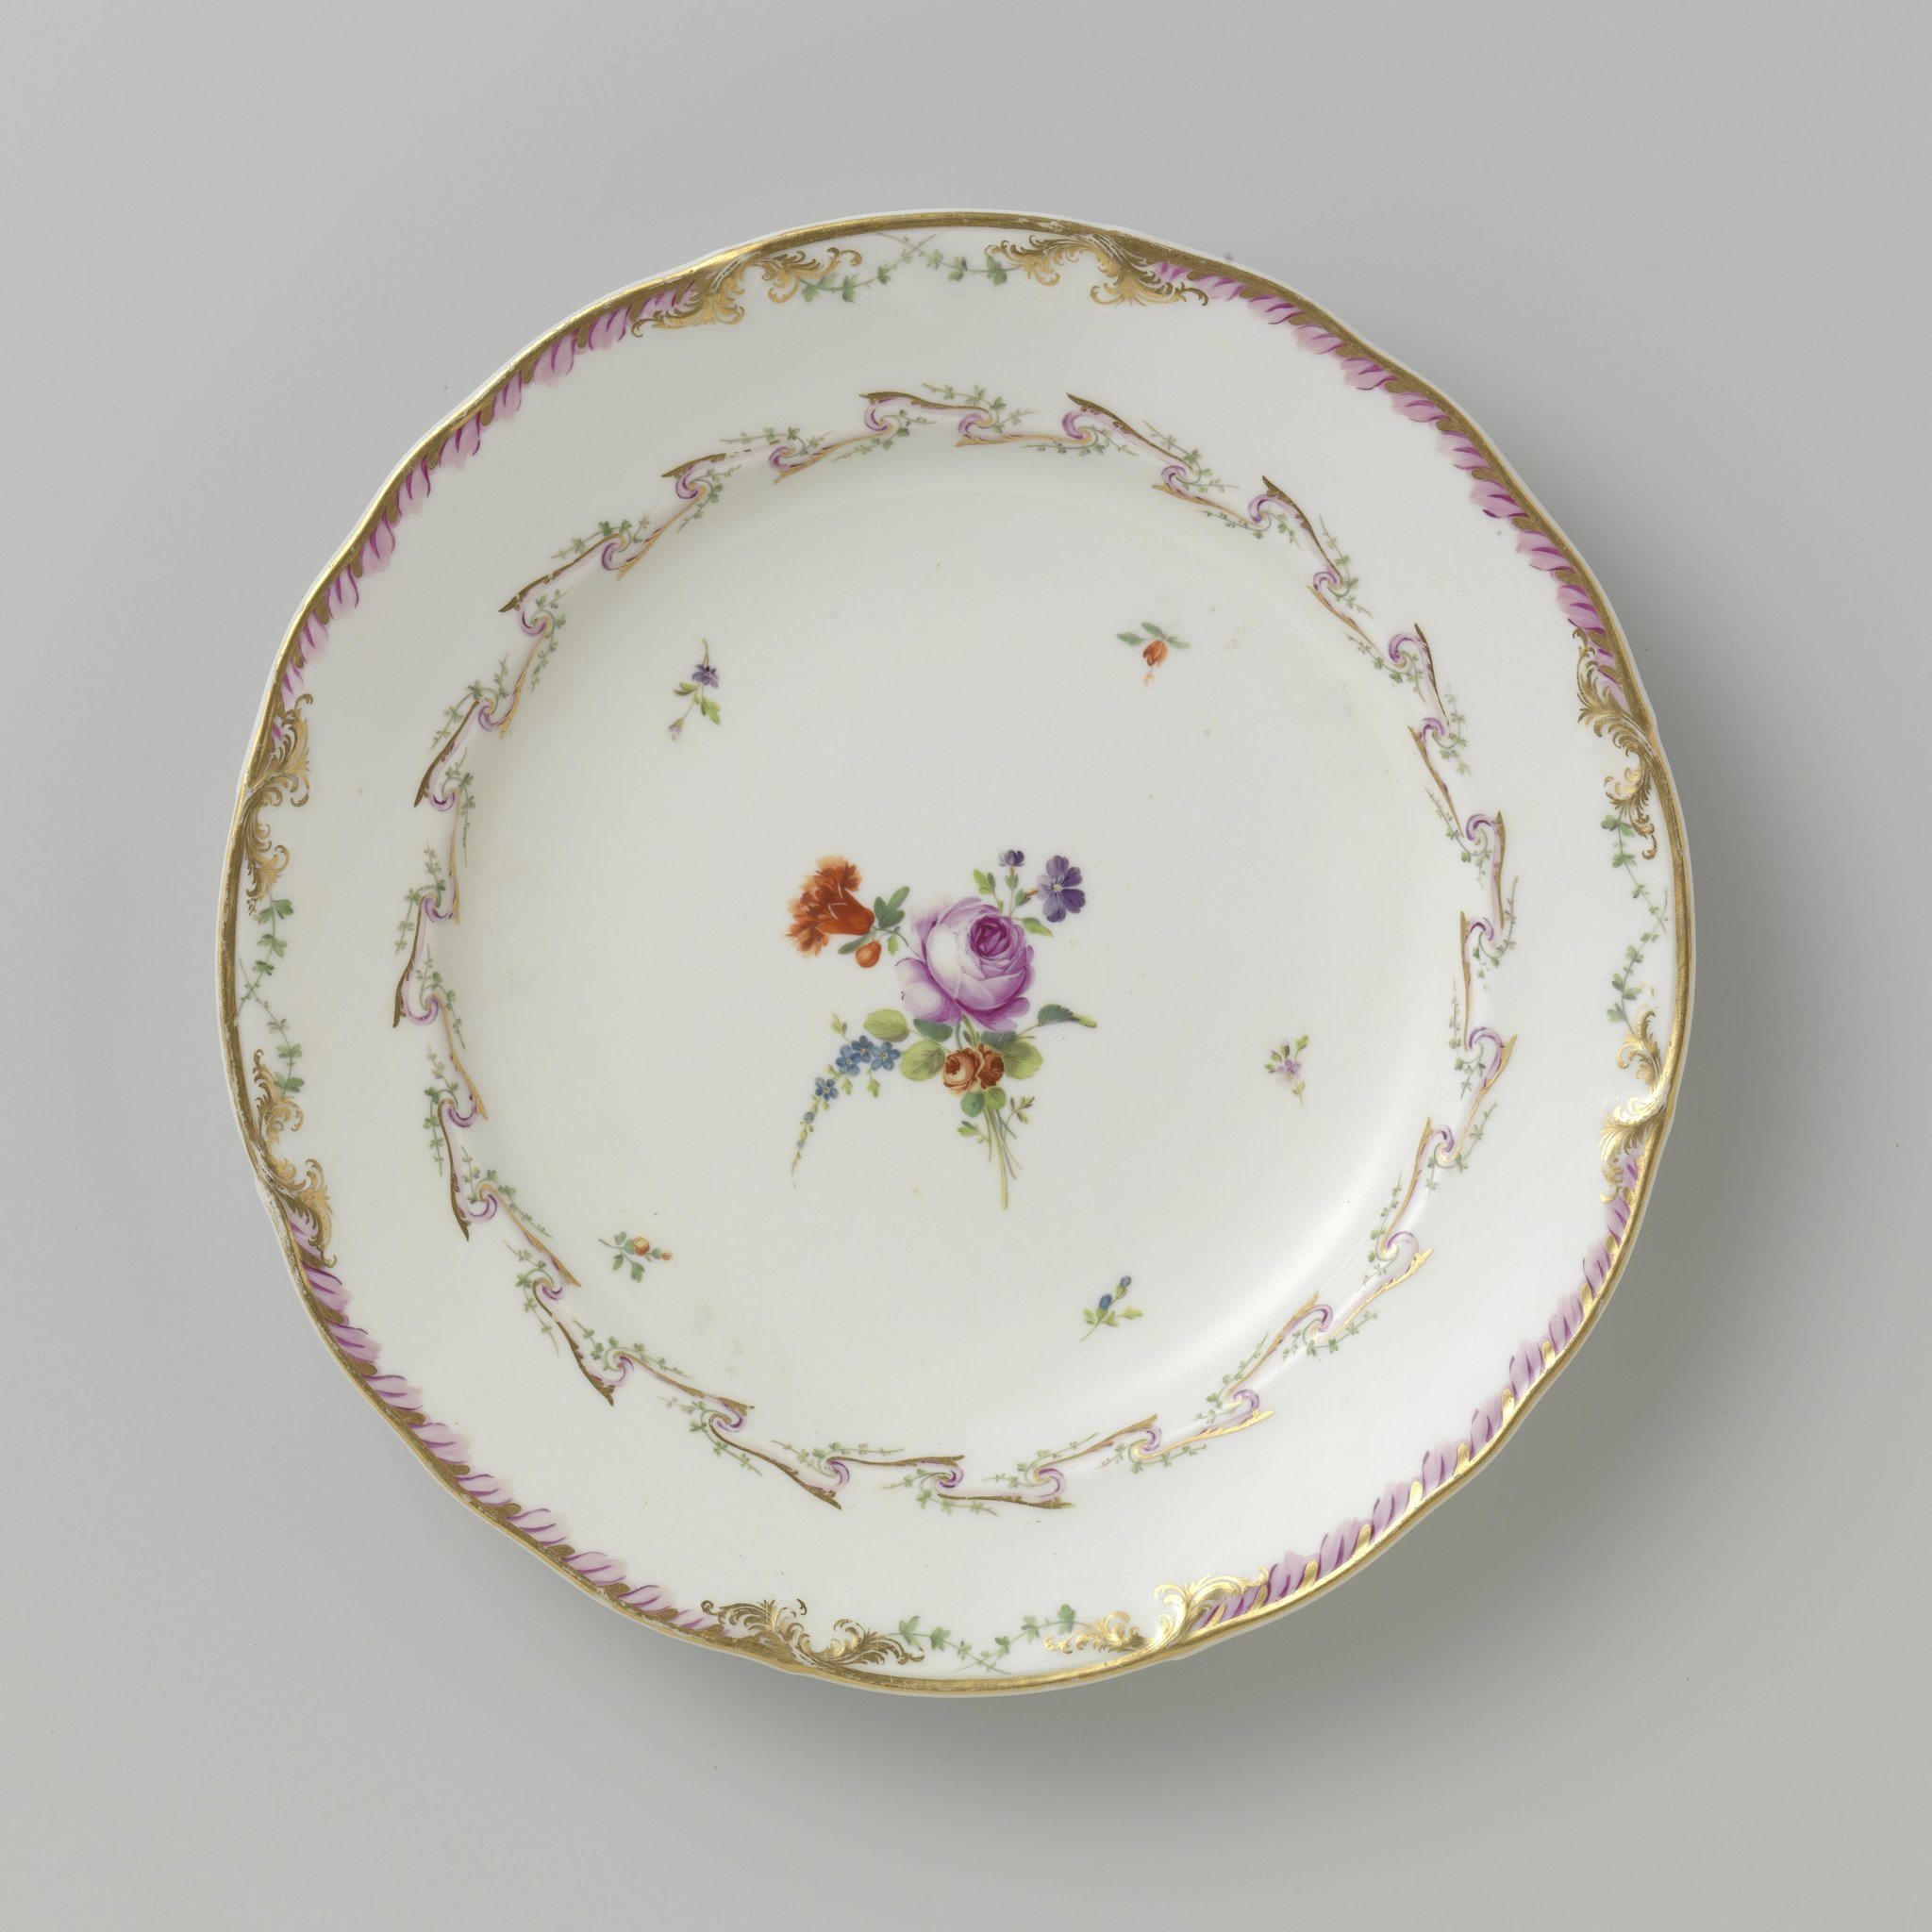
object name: plate dish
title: Bord, plat model, behorend bij een servies met geslingerd lintmotief met bladertakken, bloemboeketten en gestrooide bloemtakken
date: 1780-1820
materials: porcelain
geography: amsterdam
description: Bord, plat model, behorend bij een servies van porselein met geslingerd lintmotief in paars en goud met groene bladertakken, bloemboeketten en gestrooide bloemtakken. Randen lichtgegolfd met decoratie in goud met paars bladmotief waartussen groen gekruist bladmotief. Gemerkt: M.O.L. of AMSTEL.